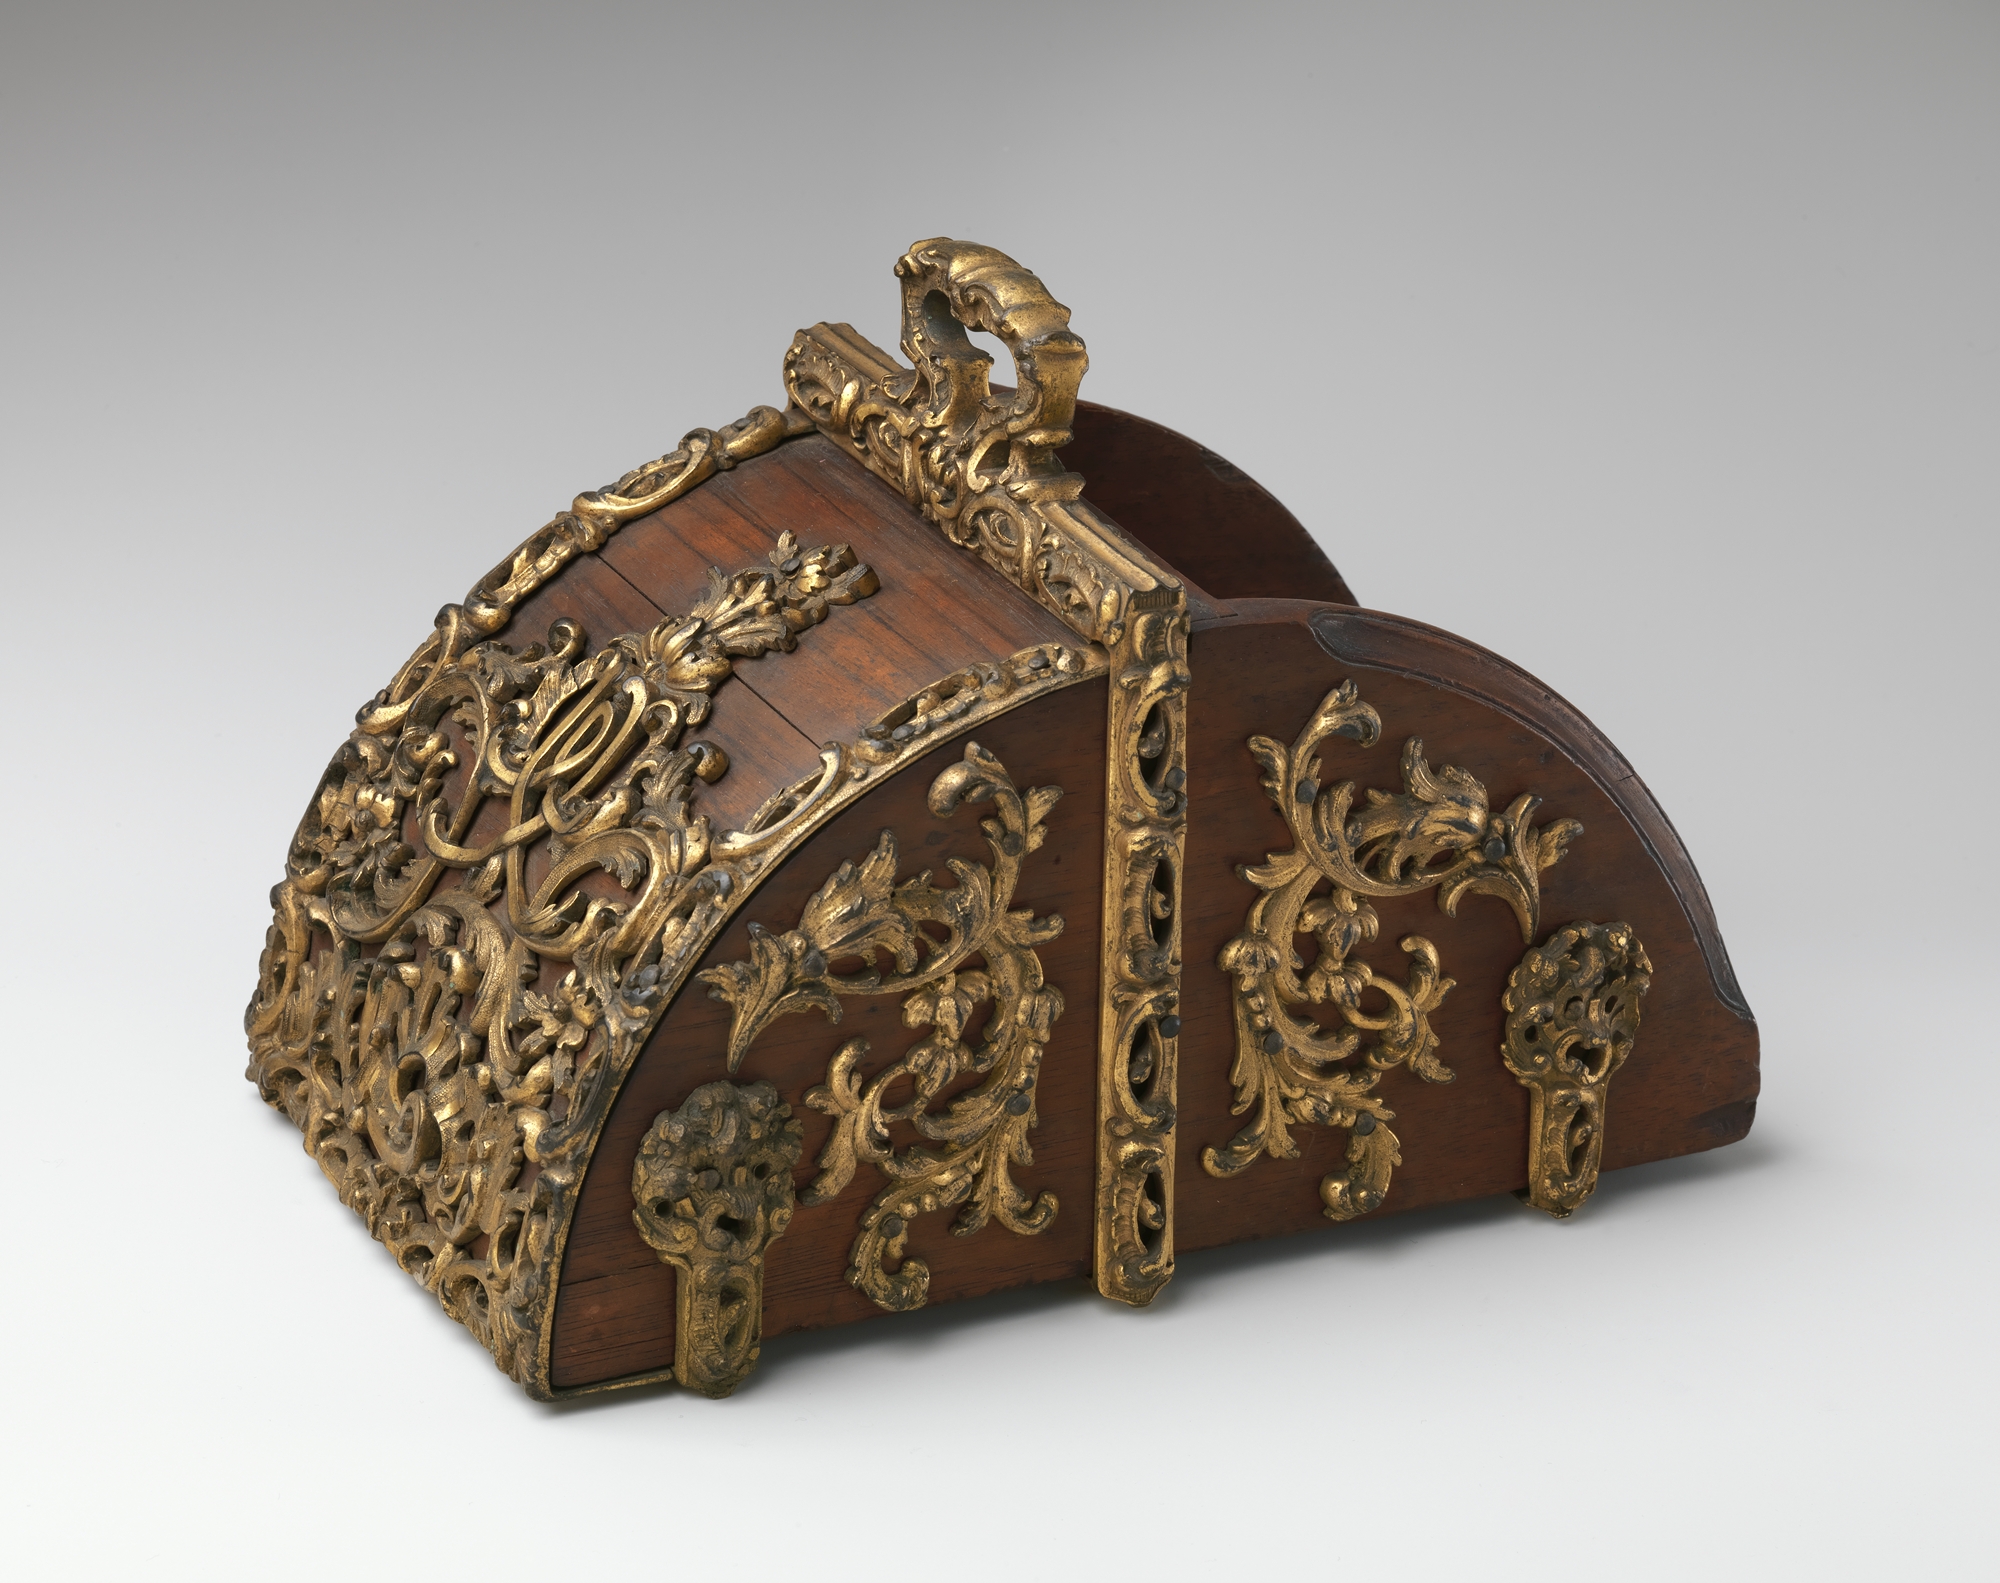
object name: stirrup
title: Pair of stirrups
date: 1750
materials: bronze, gilt, wood